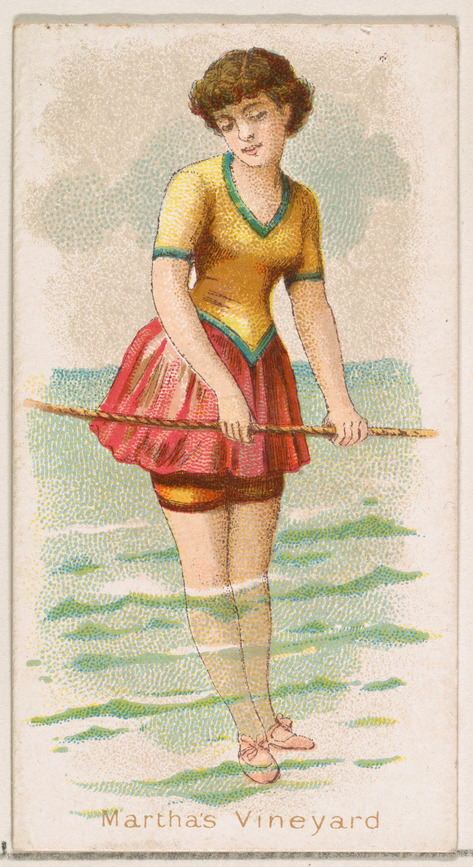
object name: print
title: Martha's Vineyard, from the Fancy Bathers series (N187) issued by Wm. S. Kimball & Co.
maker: william s. kimball & company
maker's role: publisher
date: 1889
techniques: color lithograph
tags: girls